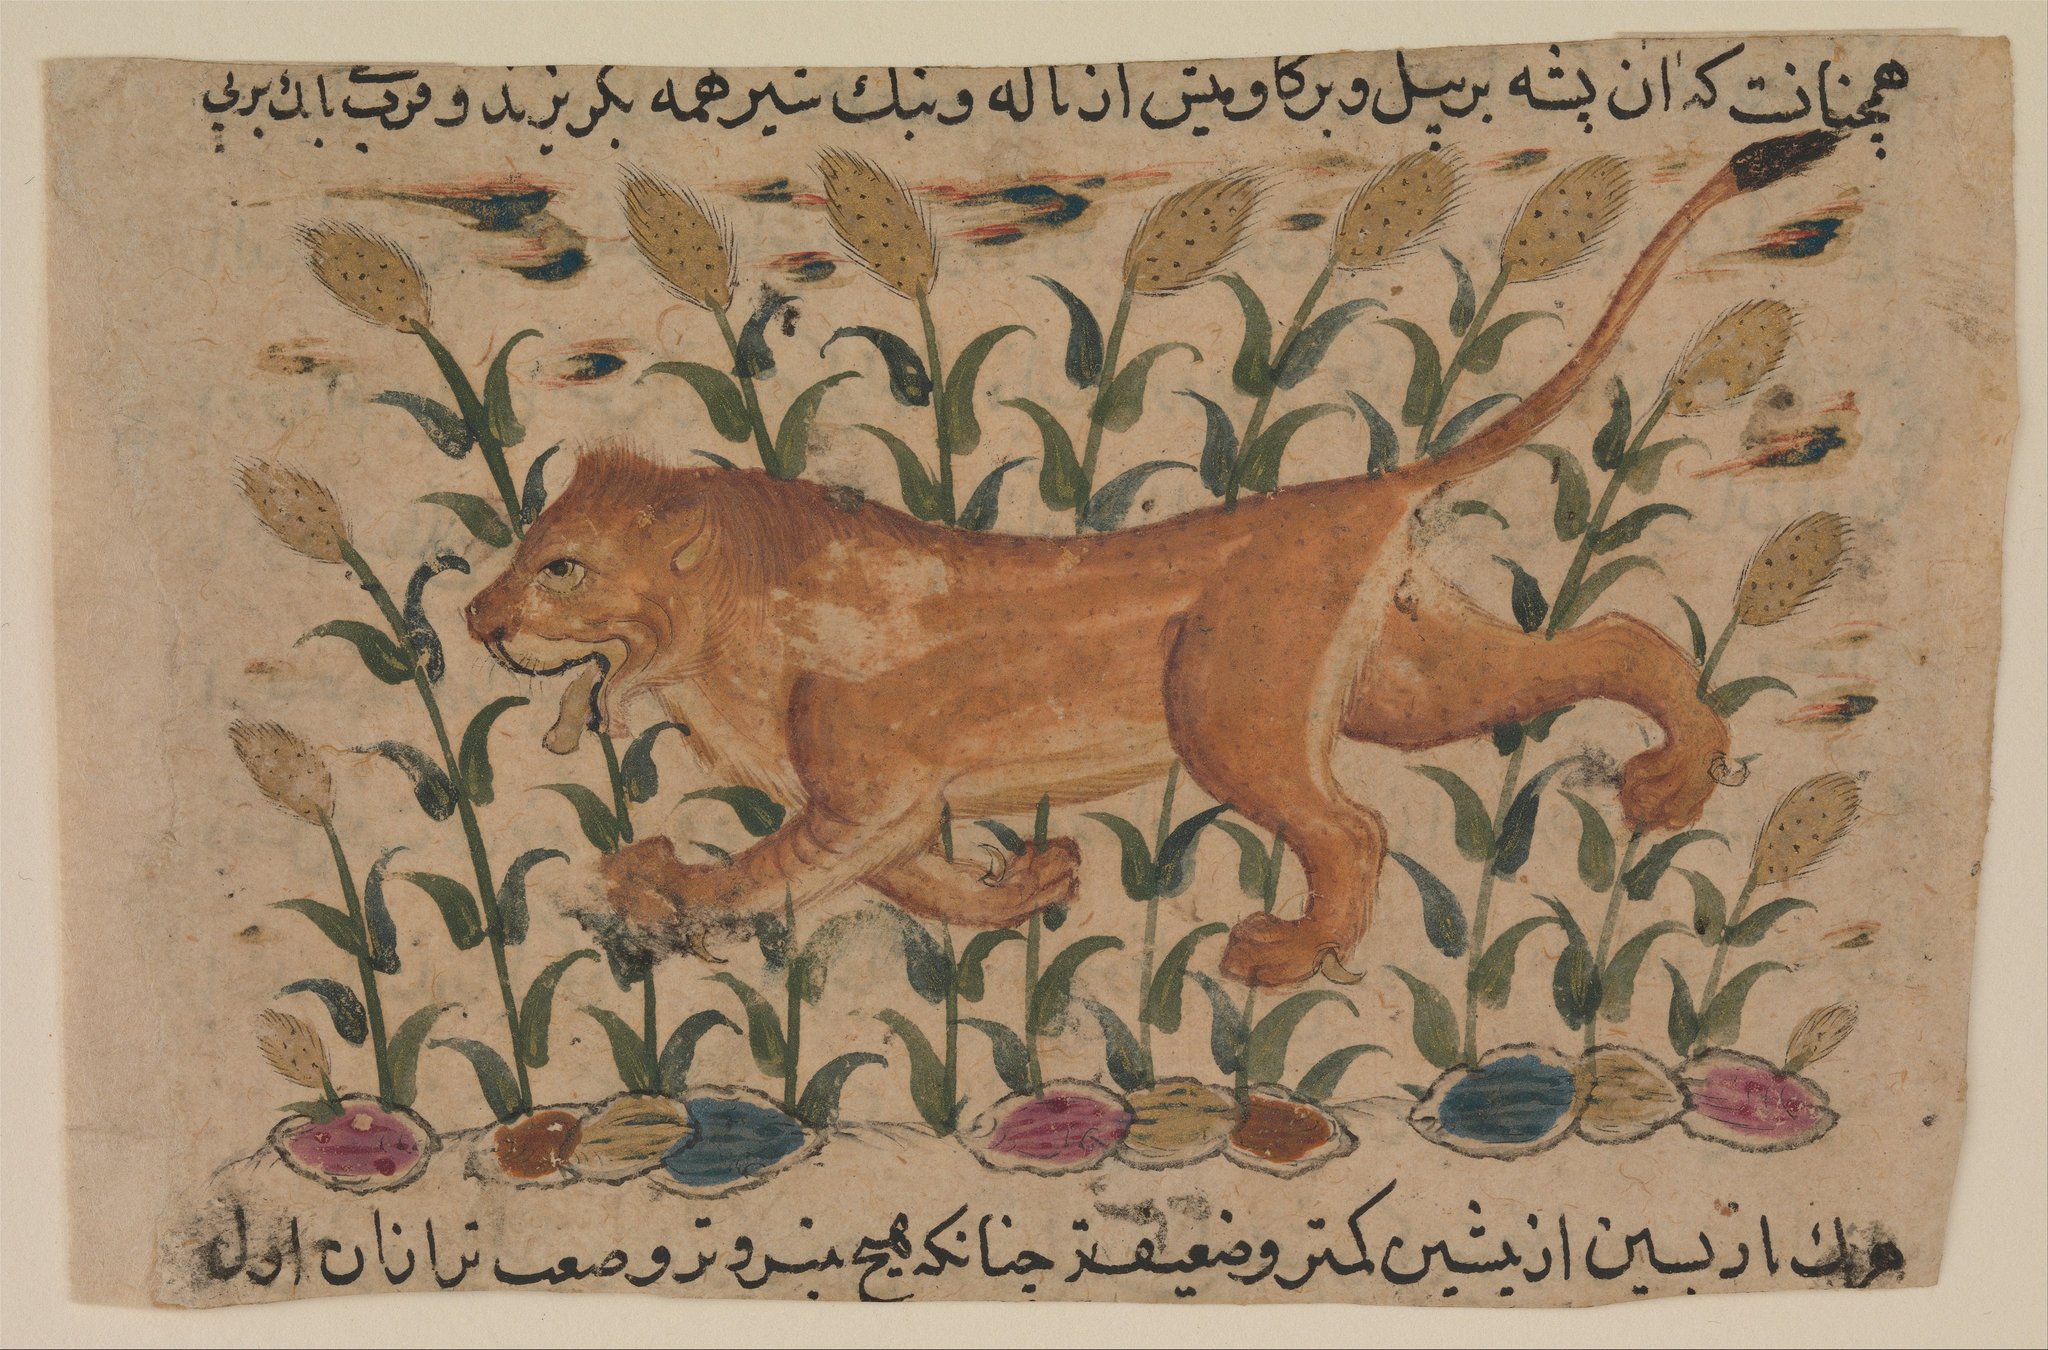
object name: folio from an illustrated manuscript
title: " A Lion", Folio from a Dispersed Nuzhatnama-i ‘Ala’i of Shahmardan ibn Abi’l Khayr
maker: shamardan ibn abi 'l khayr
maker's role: author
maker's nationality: iranian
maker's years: 1075-1125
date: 1601-1633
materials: gold, ink, paper, watercolor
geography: iran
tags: lions,plants